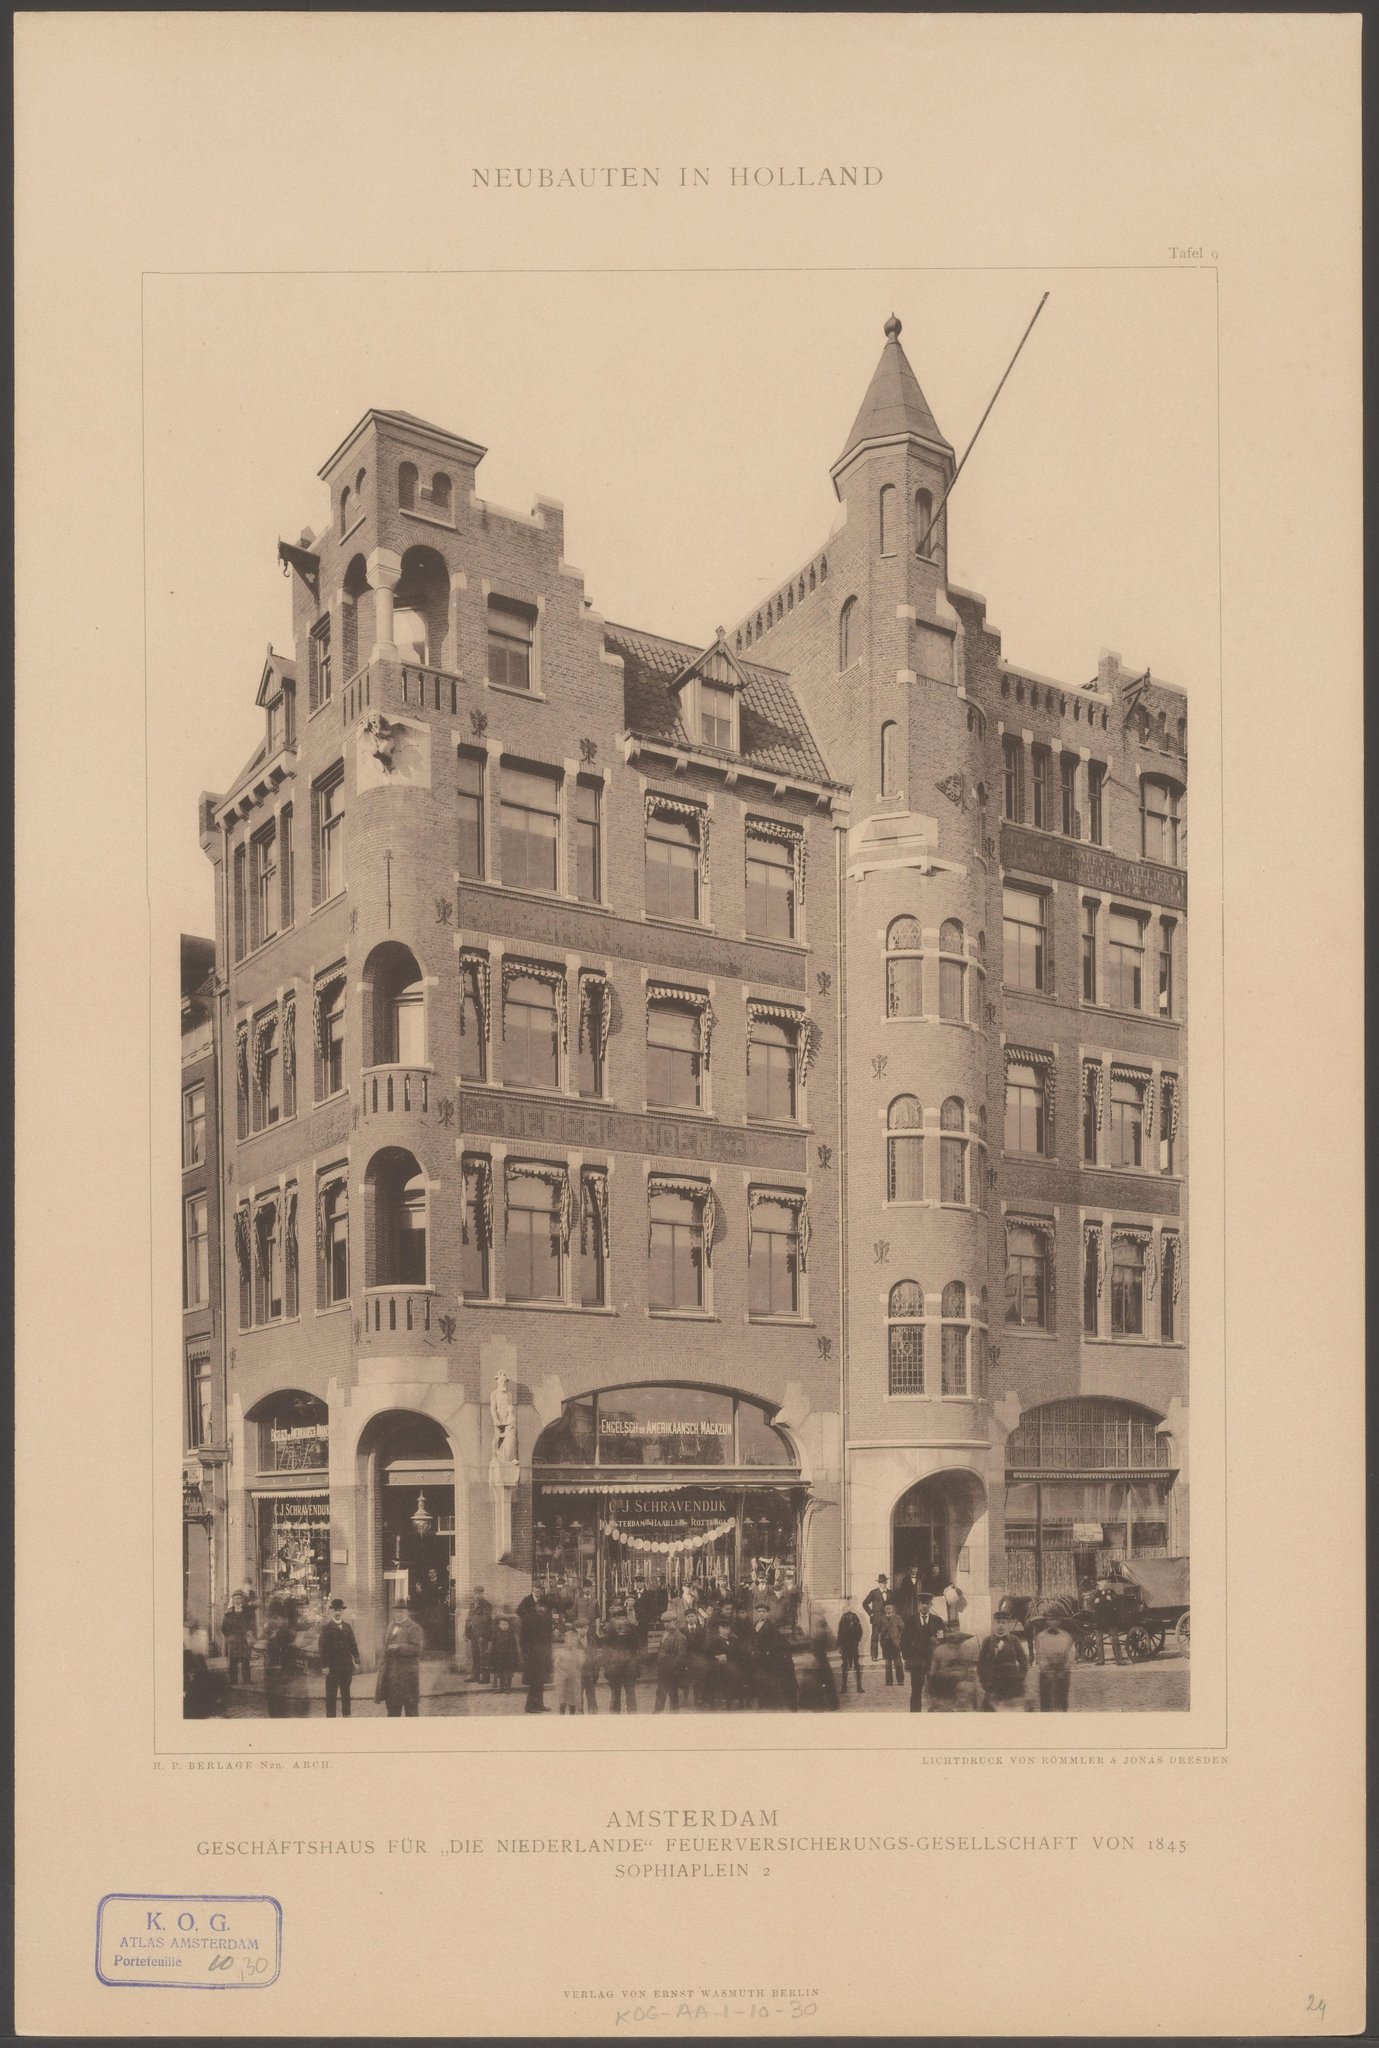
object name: photomechanical print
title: Gezicht op het kantoor van verzekeringsmaatschappij De Nederlanden van 1845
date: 1900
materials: paper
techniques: photograph, letterpress printing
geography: amsterdam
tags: square, place, circus, etc., insurance, city-view in general; 'veduta', façade (of house or building)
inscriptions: collector's mark: ‘10,30’ Lugt 1641b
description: Onderwerpsrubriek binnen de Atlas Amsterdam: Maagdelievenstraat, Markenplein, Marnixstraat, Martelaarsgracht, Meeuwenlaan, Mennonietenpad, Meijerplein (Jonas Daniël), Mozes en Aäronstraat, Muidergracht, Muntplein. Genummerd rechtsboven: Tafel 9.